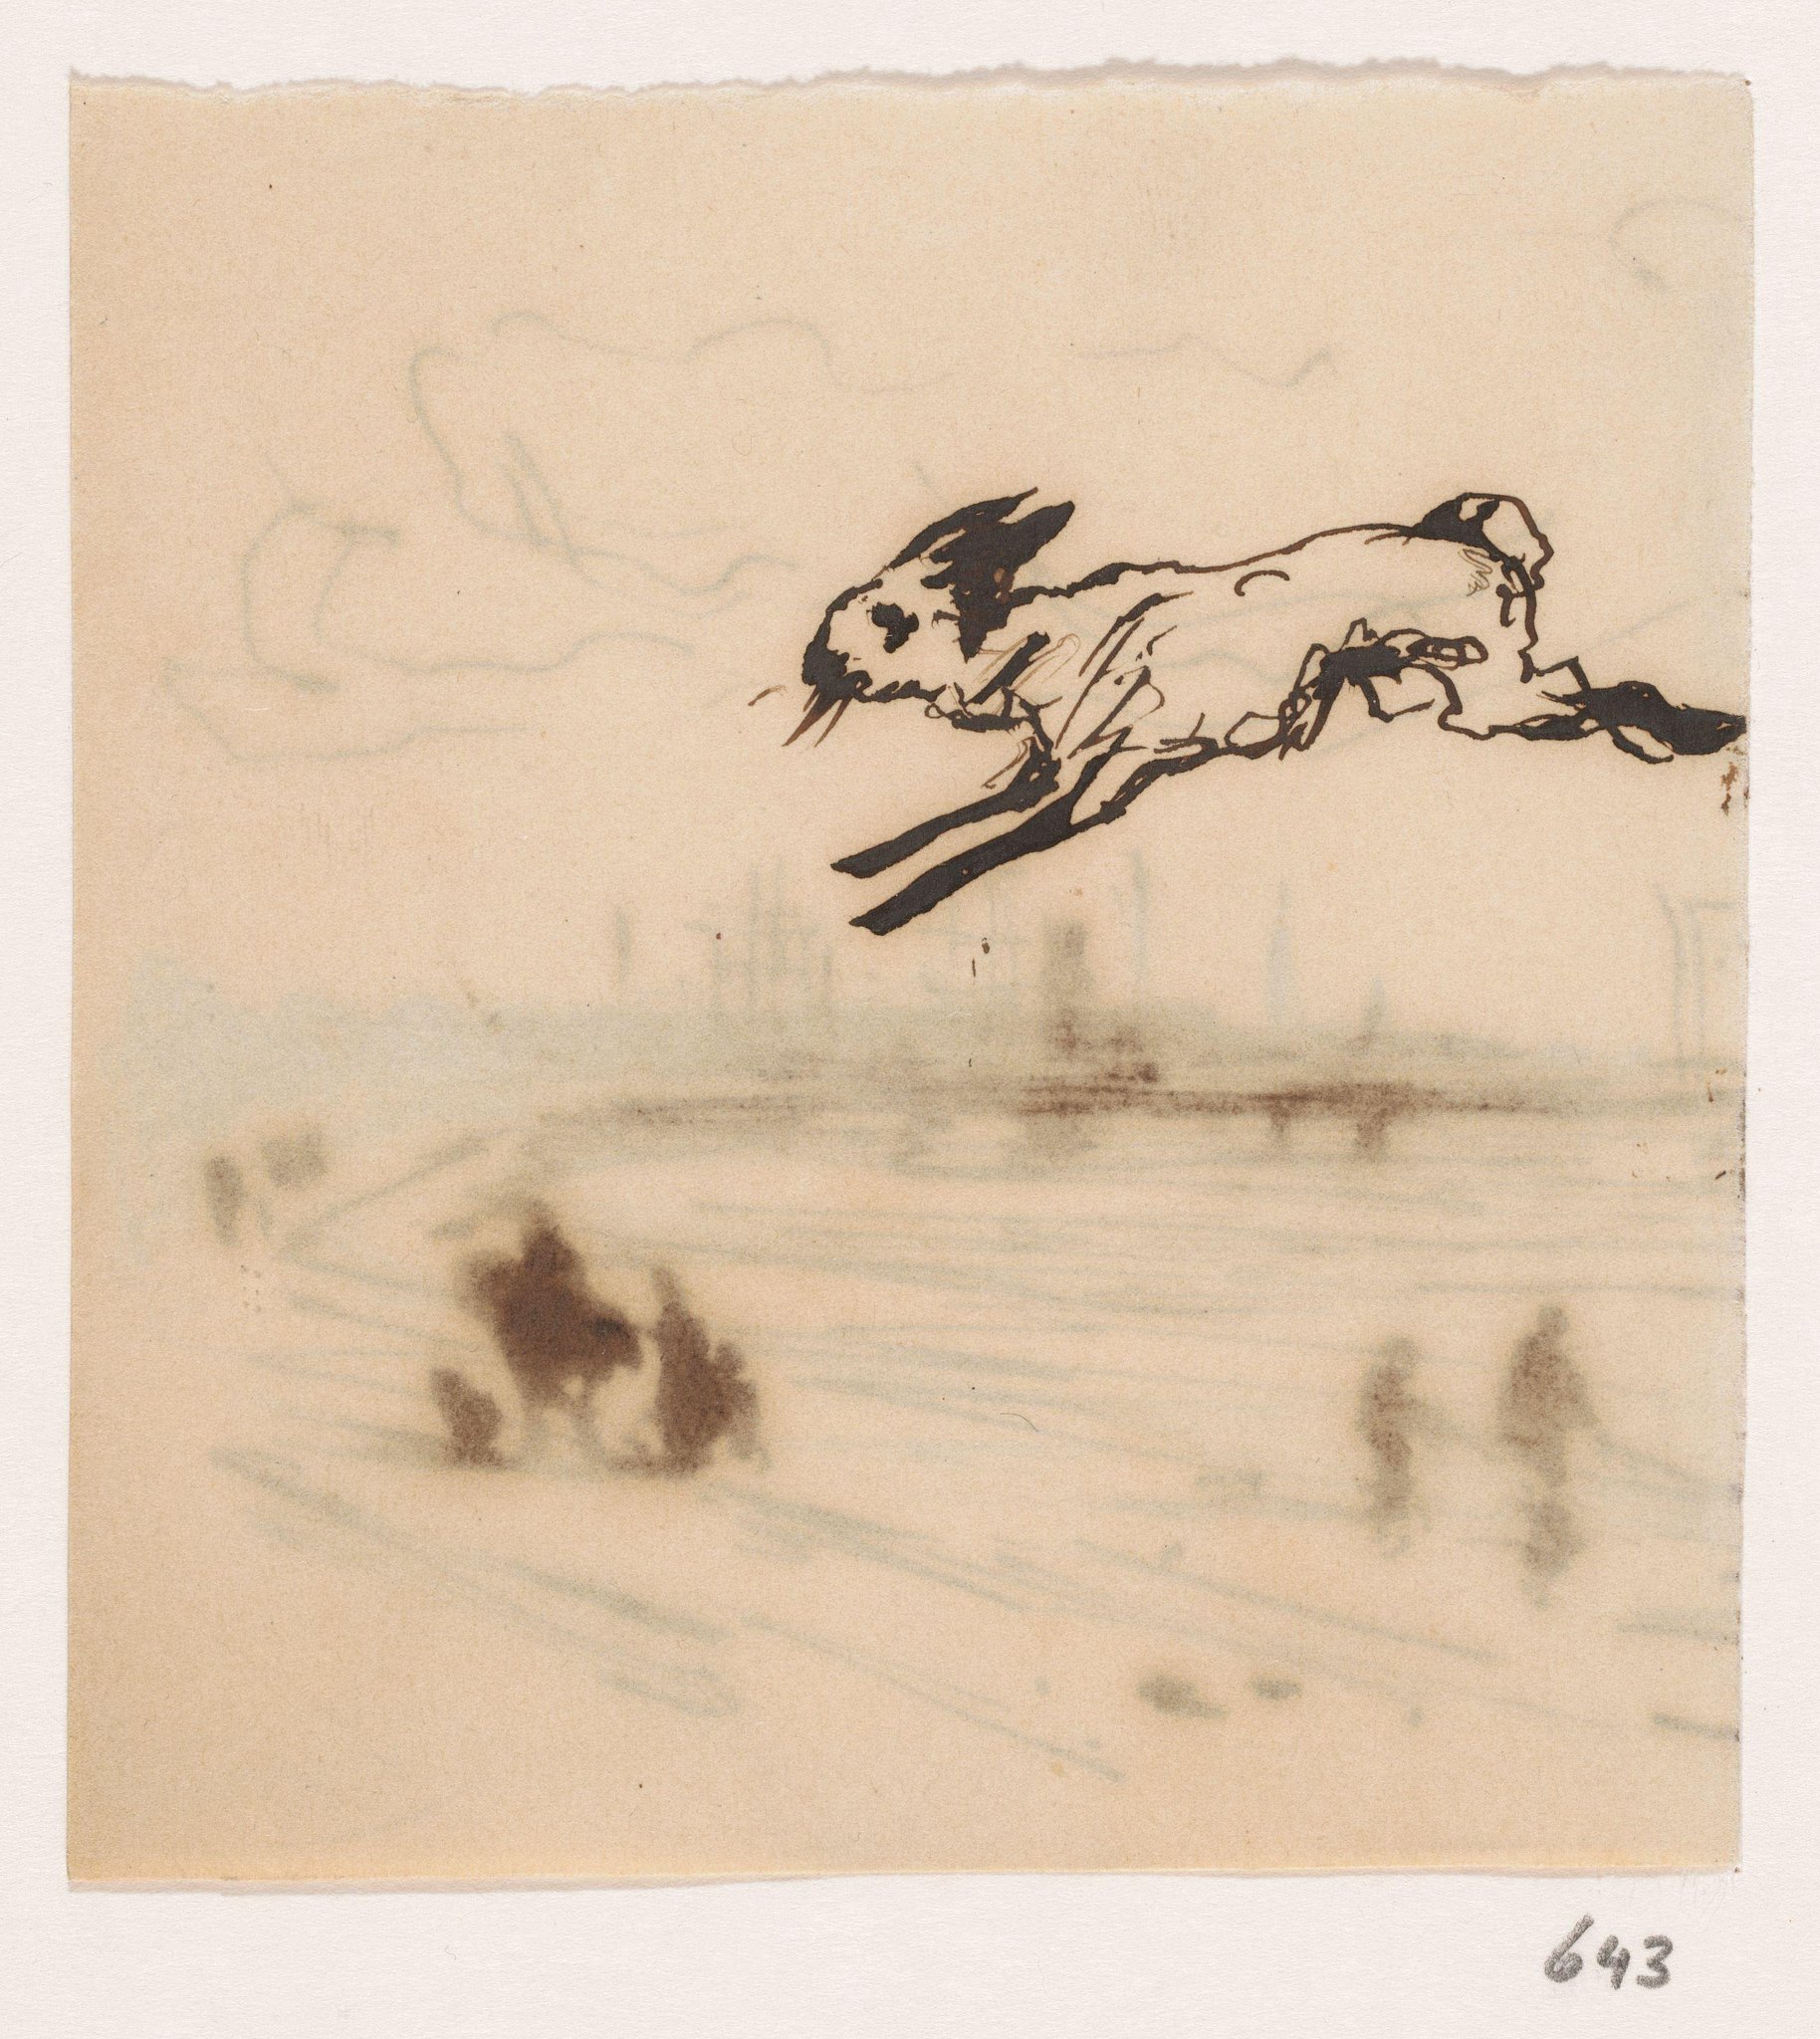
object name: drawing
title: Haas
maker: johannes tavenraat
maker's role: draughtsman, painter, print maker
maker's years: 1809-1881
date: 1840-1880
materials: ink, paper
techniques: pen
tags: rodents: hare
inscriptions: collector's mark: Lugt 2228